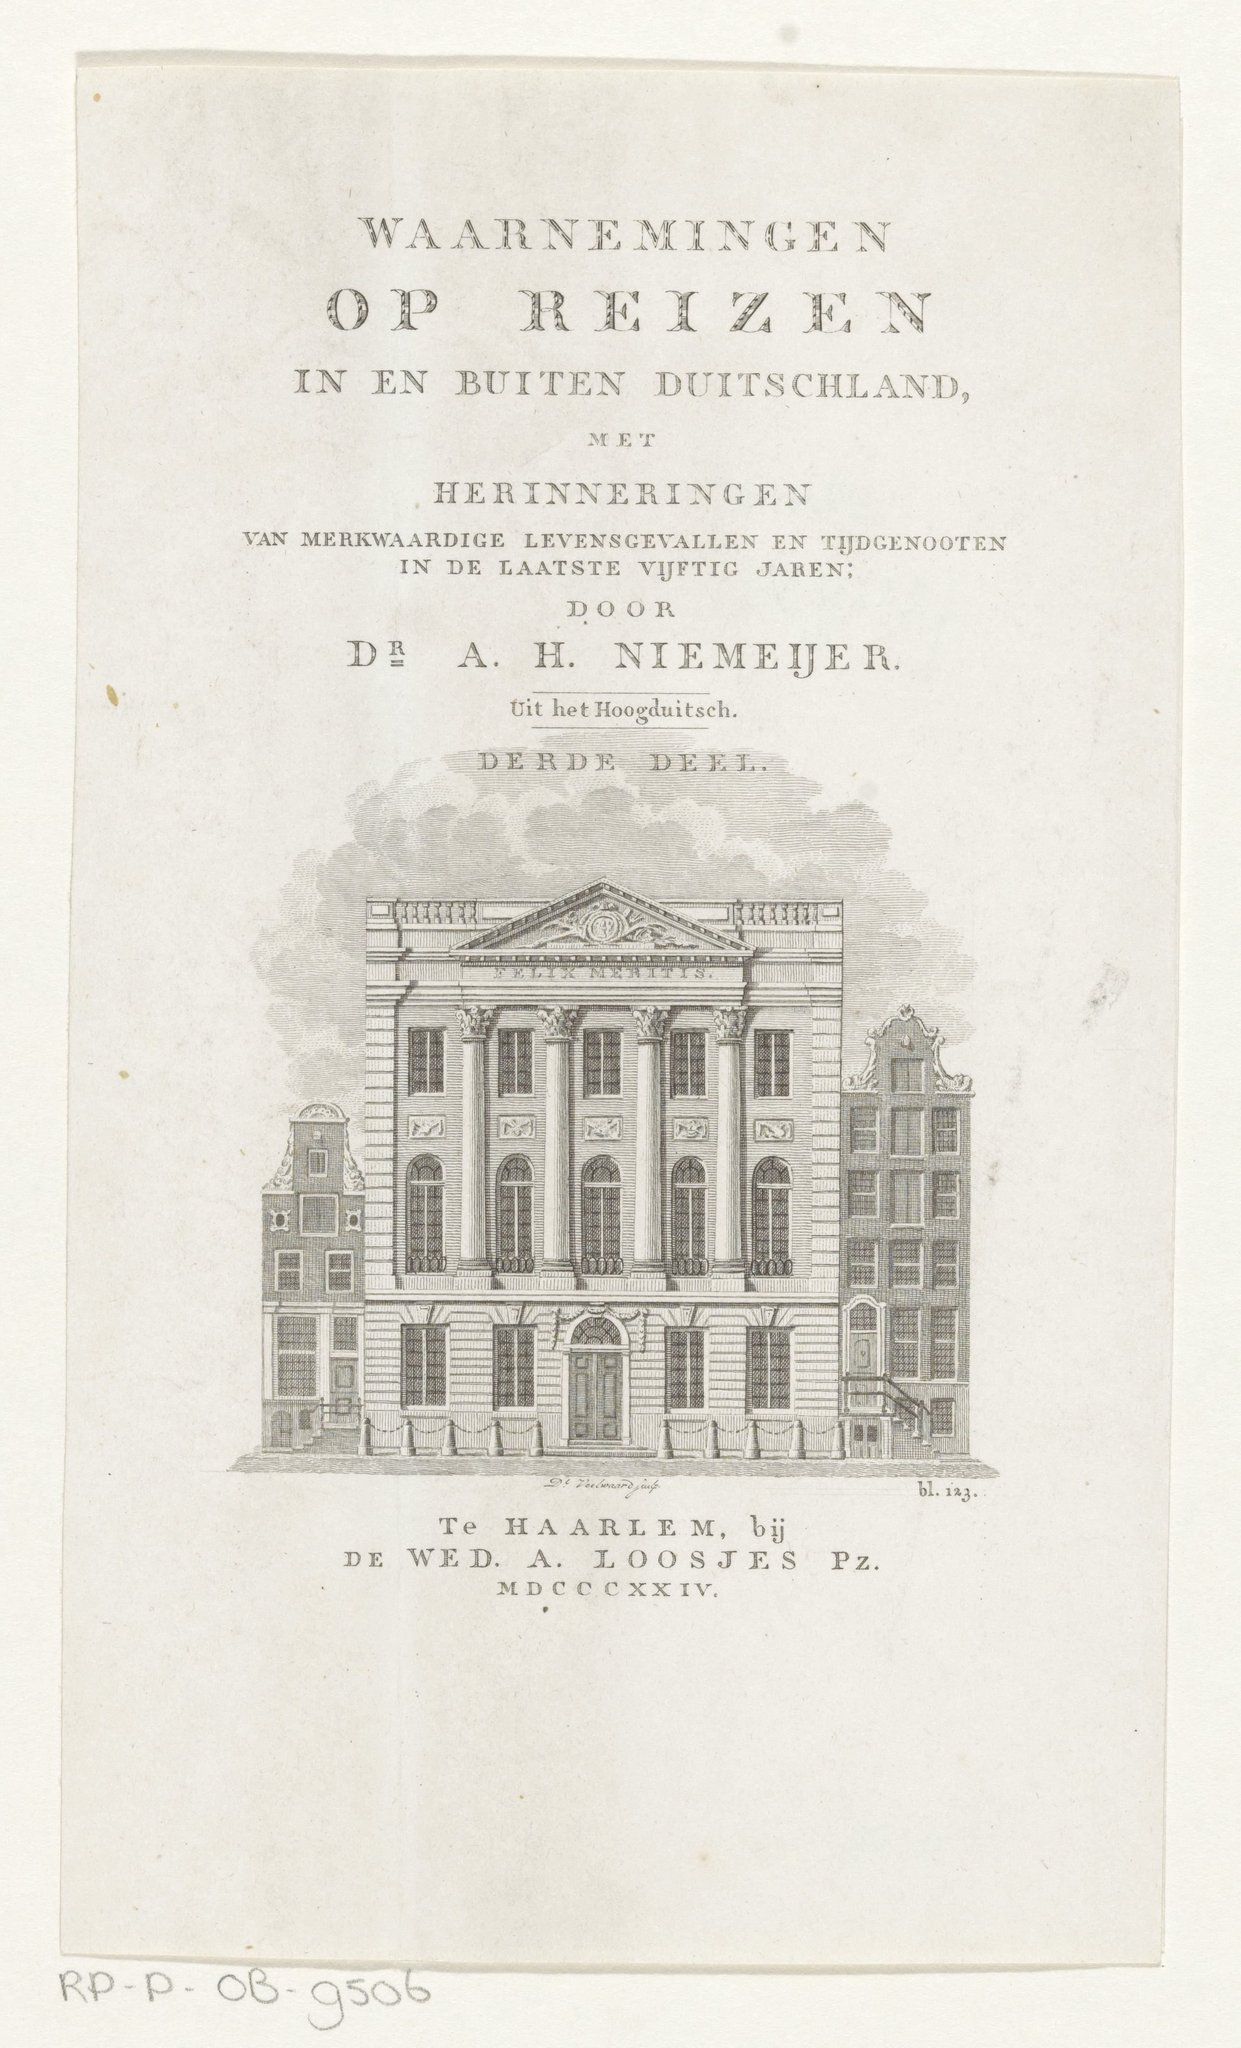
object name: print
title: Titelpagina voor: A.H. Niemeyer, Waarnemingen op Reizen in en buiten Deutschland, 1824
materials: paper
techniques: engraving, etching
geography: haarlem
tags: learned society, academy of sciences, façade (of house or building)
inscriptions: collector's mark: Lugt 2228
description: Het gebouw van het genootschap Felix Meritis te Amsterdam, dat in 1788 werd opgericht door gegoede burgers van de stad om de kunsten en wetenschappen te bevorderen.